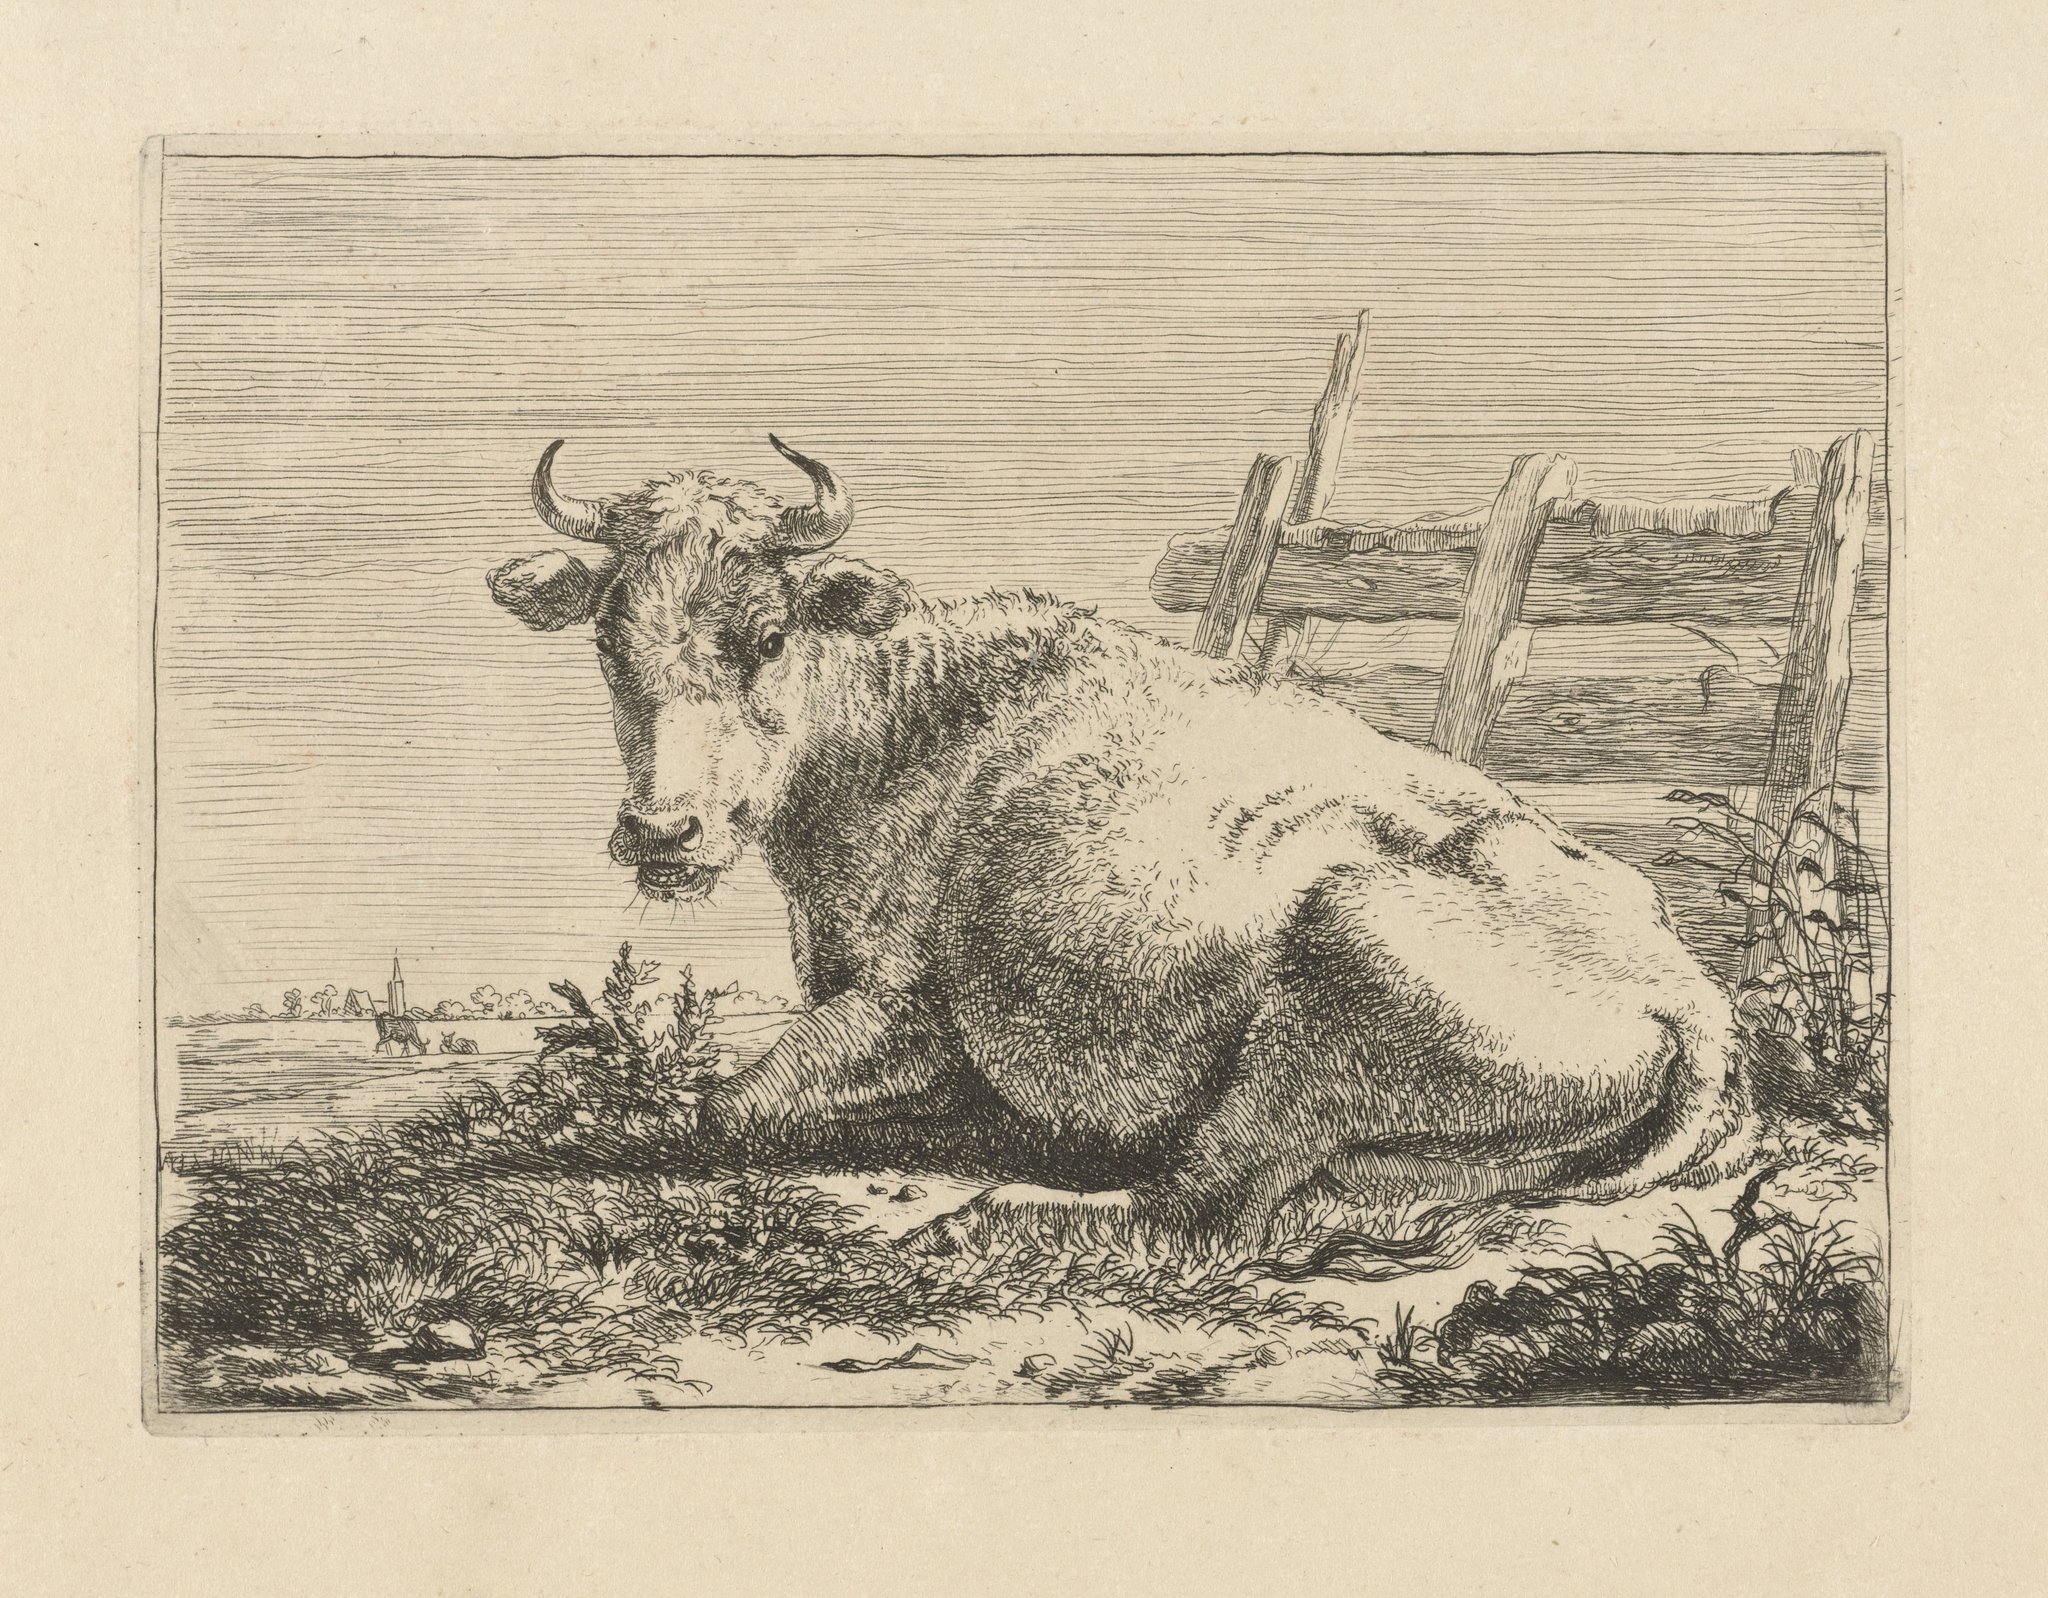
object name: print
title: Koeien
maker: pieter gerardus van os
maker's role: draughtsman, painter, print maker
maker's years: 1776-1839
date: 1798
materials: paper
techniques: etching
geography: netherlands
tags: cow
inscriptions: collector's mark: Lugt 2228